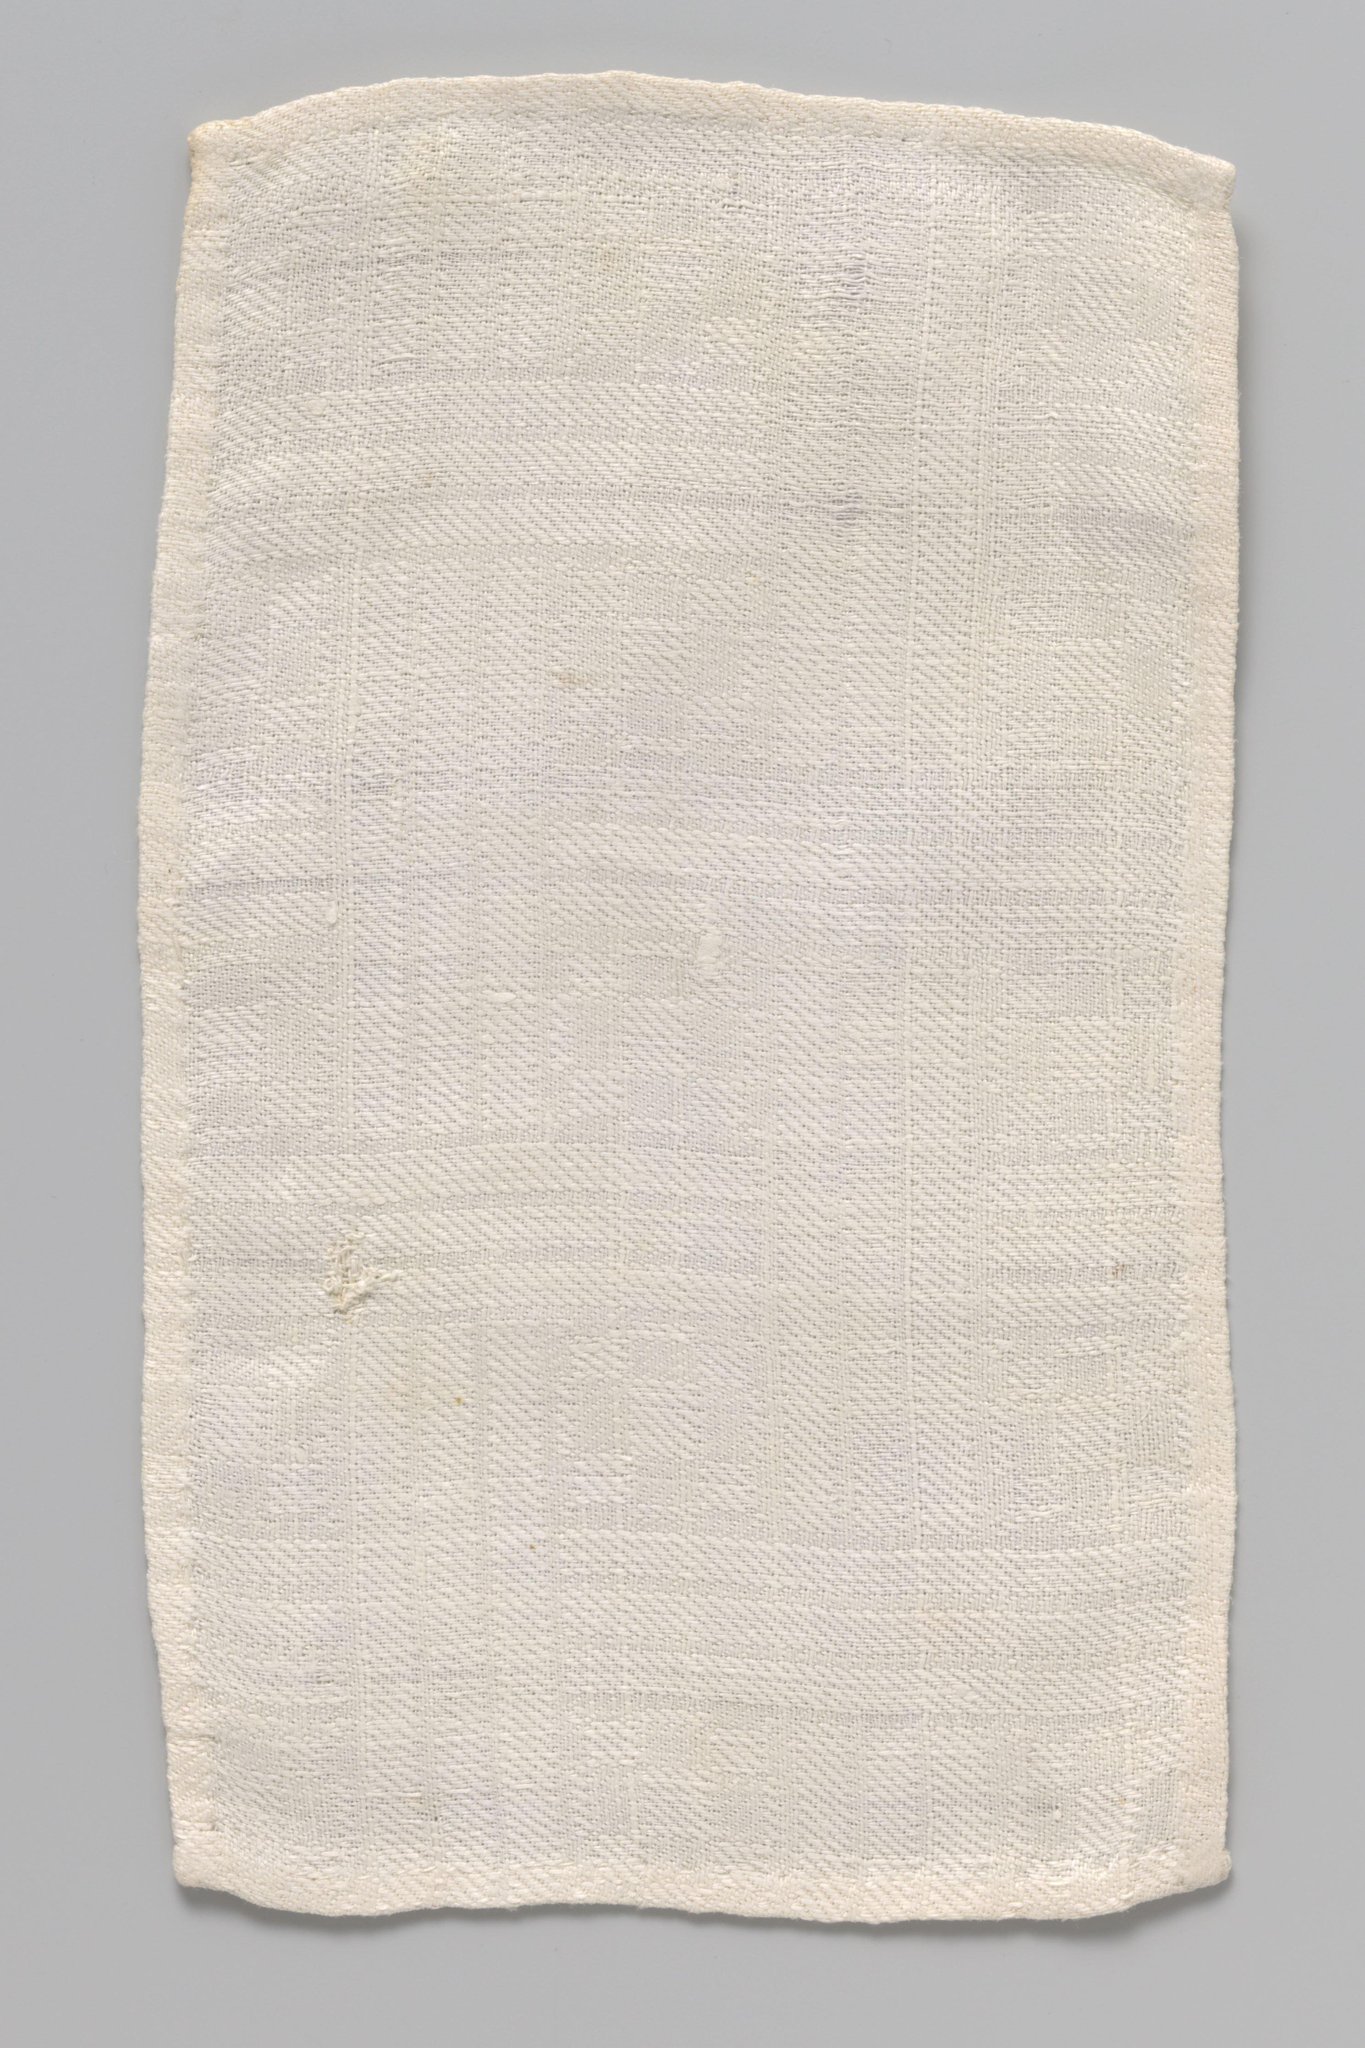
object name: poppengoed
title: Witte rechthoekige doek met ingeweven geometrisch patroon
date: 1836-1898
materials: textile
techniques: weave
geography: netherlands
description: BK-15446-13 t/m 16 en BK-2021-152 hebben hetzelfde ingeweven geometrische patroon.